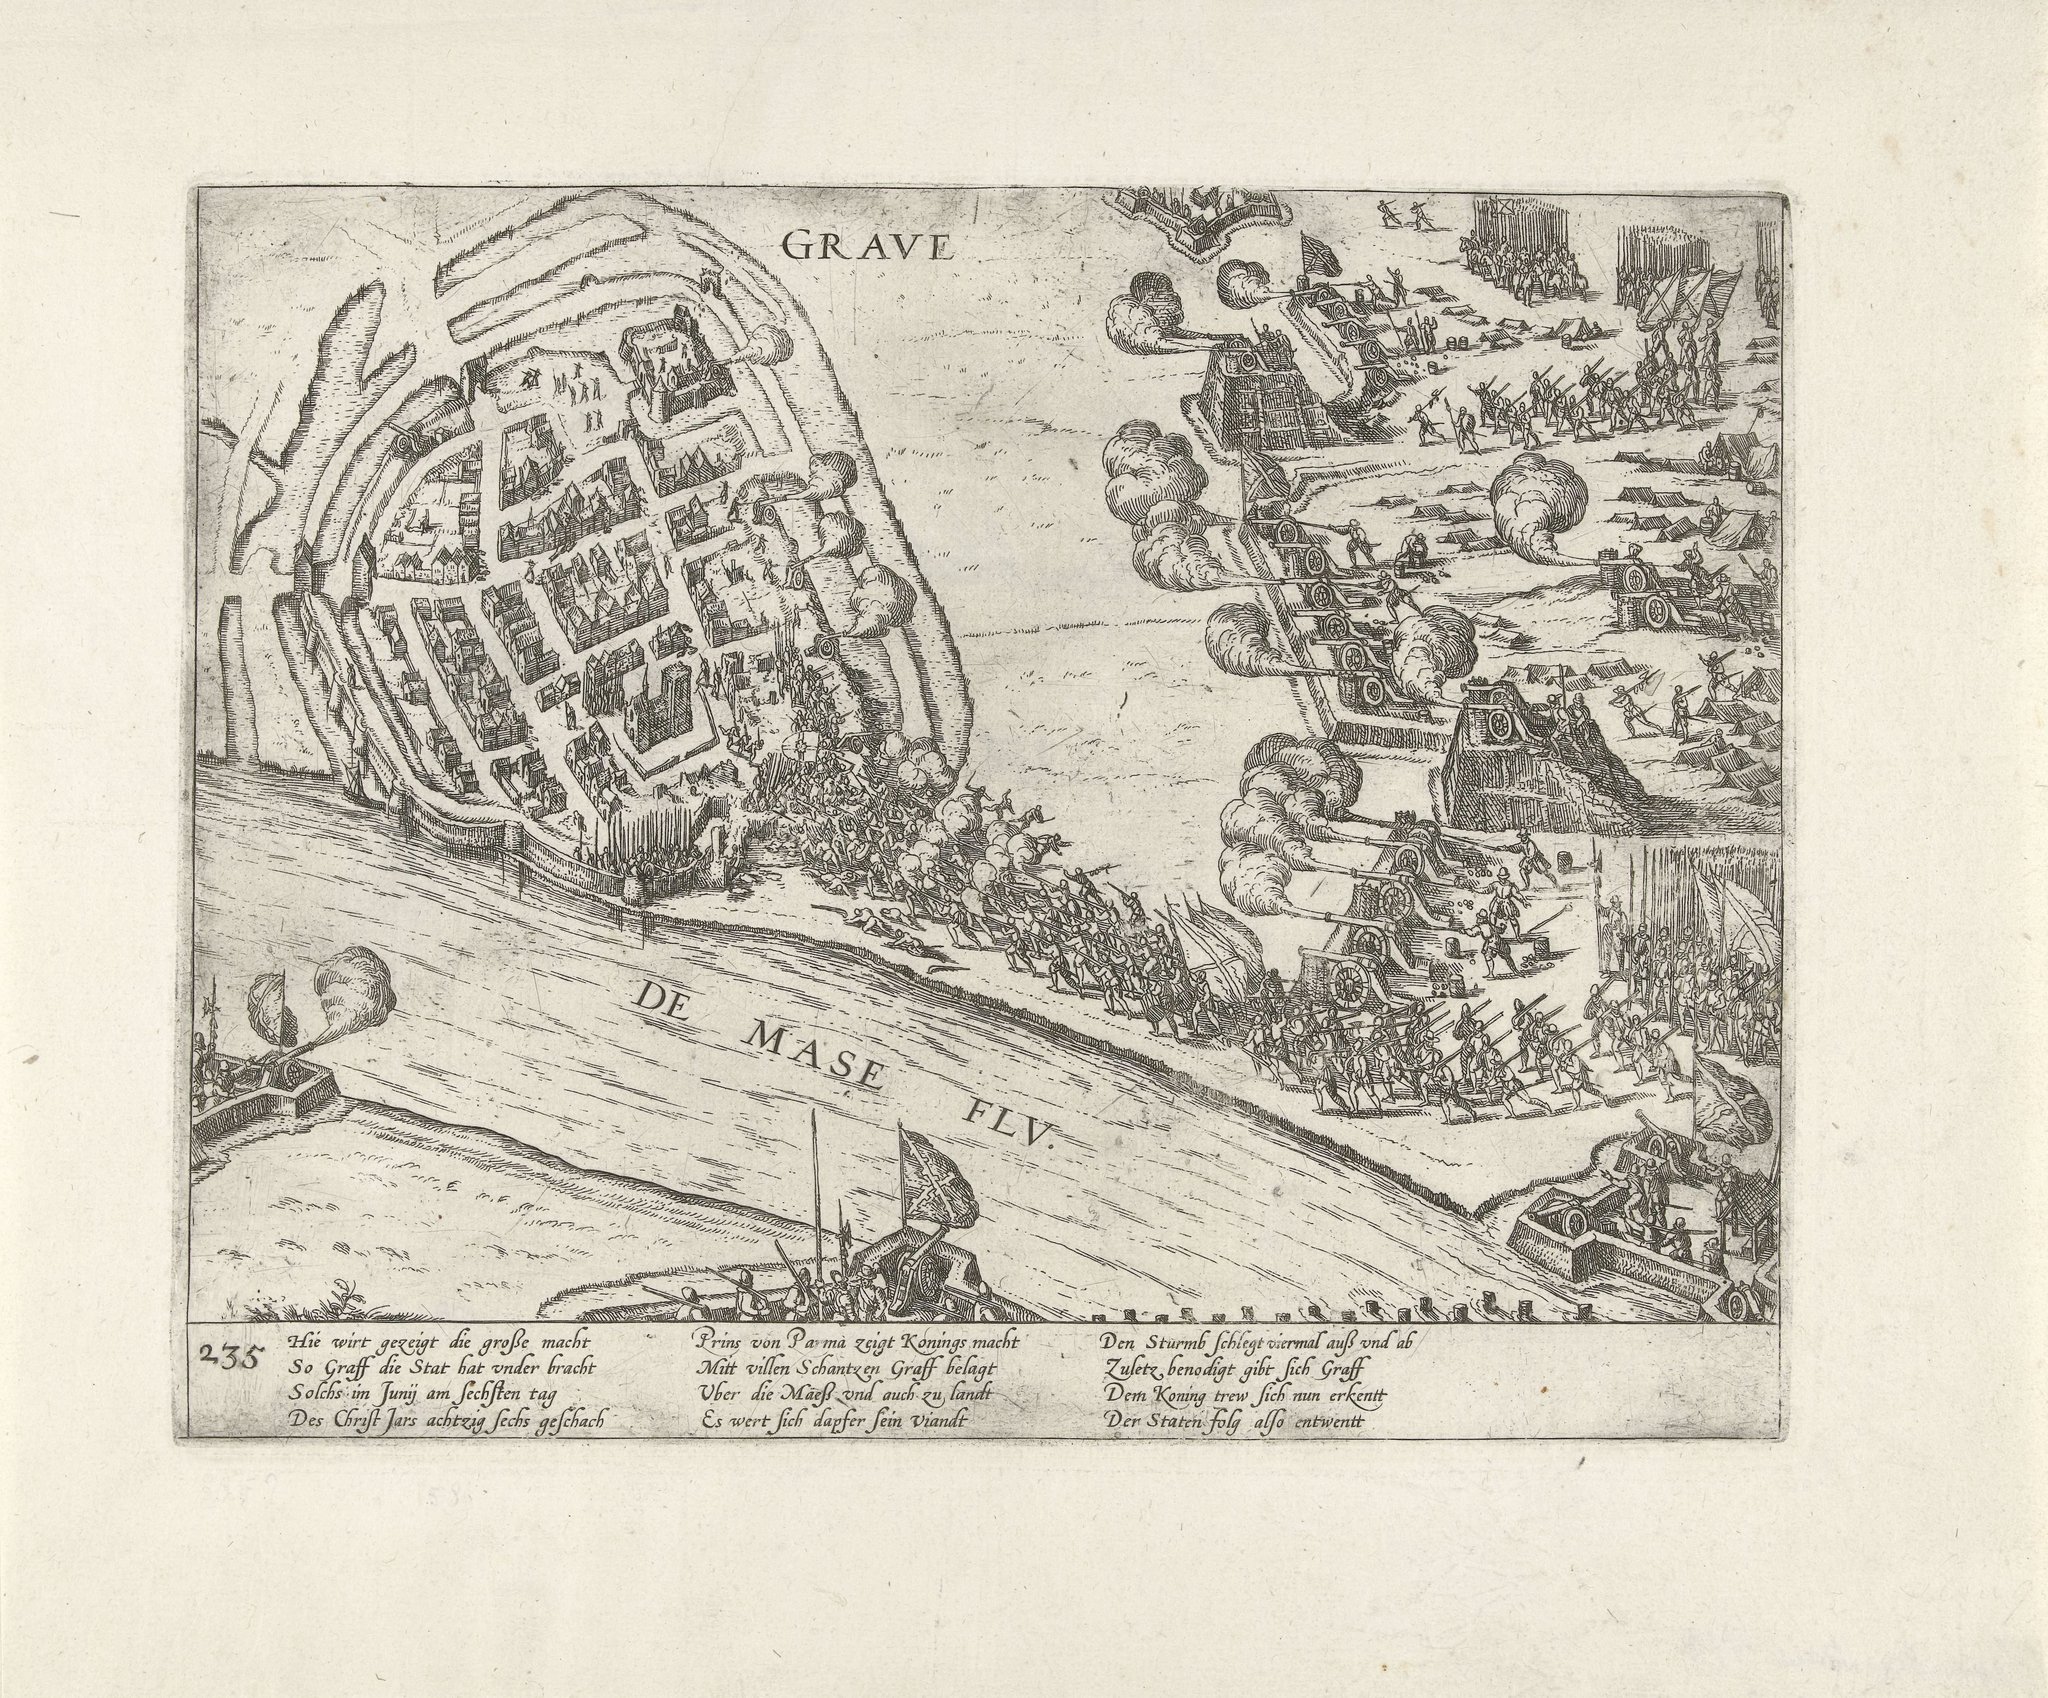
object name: print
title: Inname van Grave door Parma, 1586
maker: frans hogenberg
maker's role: print maker, publisher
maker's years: 1538-1590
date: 1586-1588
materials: paper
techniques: etching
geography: cologne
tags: rome, alessandro farnese (landvoogd van de nederlanden en hertog van parma en piacenza), siege, position war, capture of city (after the siege), grave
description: Beleg en inname van Grave door Parma, 6 juni 1586. Het leger van Parma bestormt een bres in de muren. Op de voorgrond de Maas. Met onderschrift van 12 regels in het Duits. Genummerd: 235.